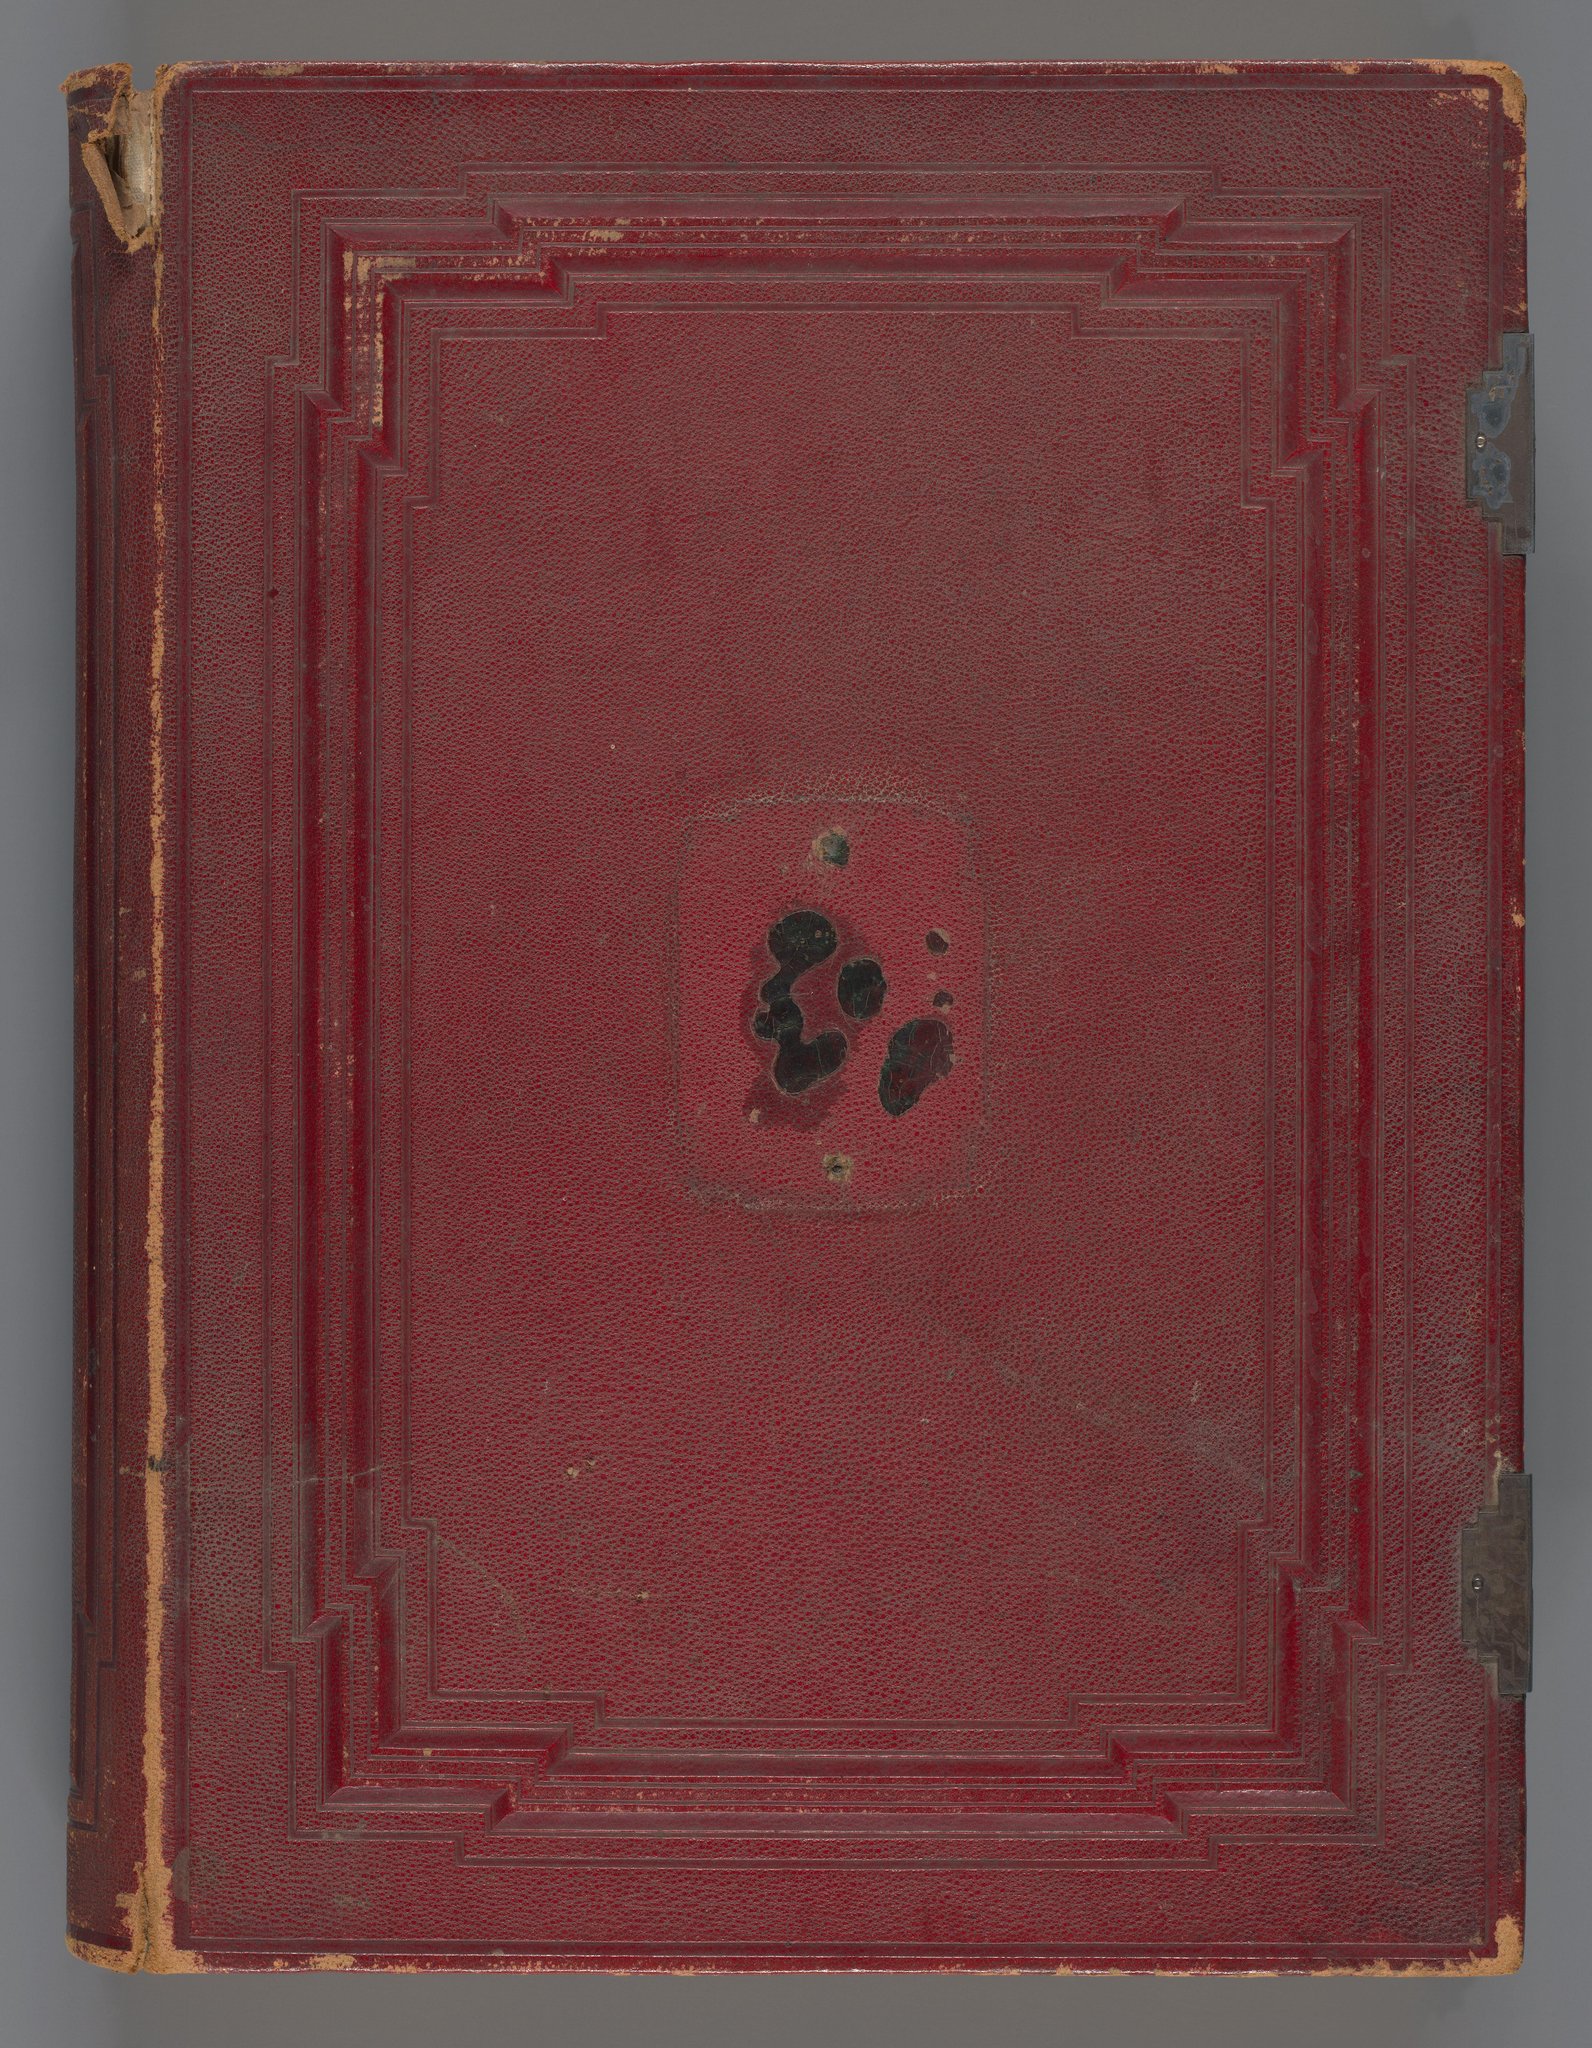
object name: slip in album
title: Fotoalbum met 113 fotografische reproducties op carte-de-visite-formaat van 17de-eeuwse Nederlandse schilderijen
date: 1860-1880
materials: cardboard, leather, metal, paper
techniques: albumen print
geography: netherlands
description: Fotoalbum met een leren omslag en goud op de snee, met 30 pagina's, waarvan één pagina geen foto's bevat. Het fotoalbum bevat 113 ingestoken cart-de-visite albumine-afdrukken, allen fotoreproducties van schilderijen (en prenten naar schilderijen) van Nederlandse schilders zoals Rembrandt van Rijn, Gerard Dou, Ferdinand Bol, Frans van Mieris en David Teniers (II). Bij het album gevoegd is een handgeschreven index, waarvan de werken en vervaardigers niet geheel kloppen en waarvan de laatste nummers (106 tot en met 113) ontbreken.